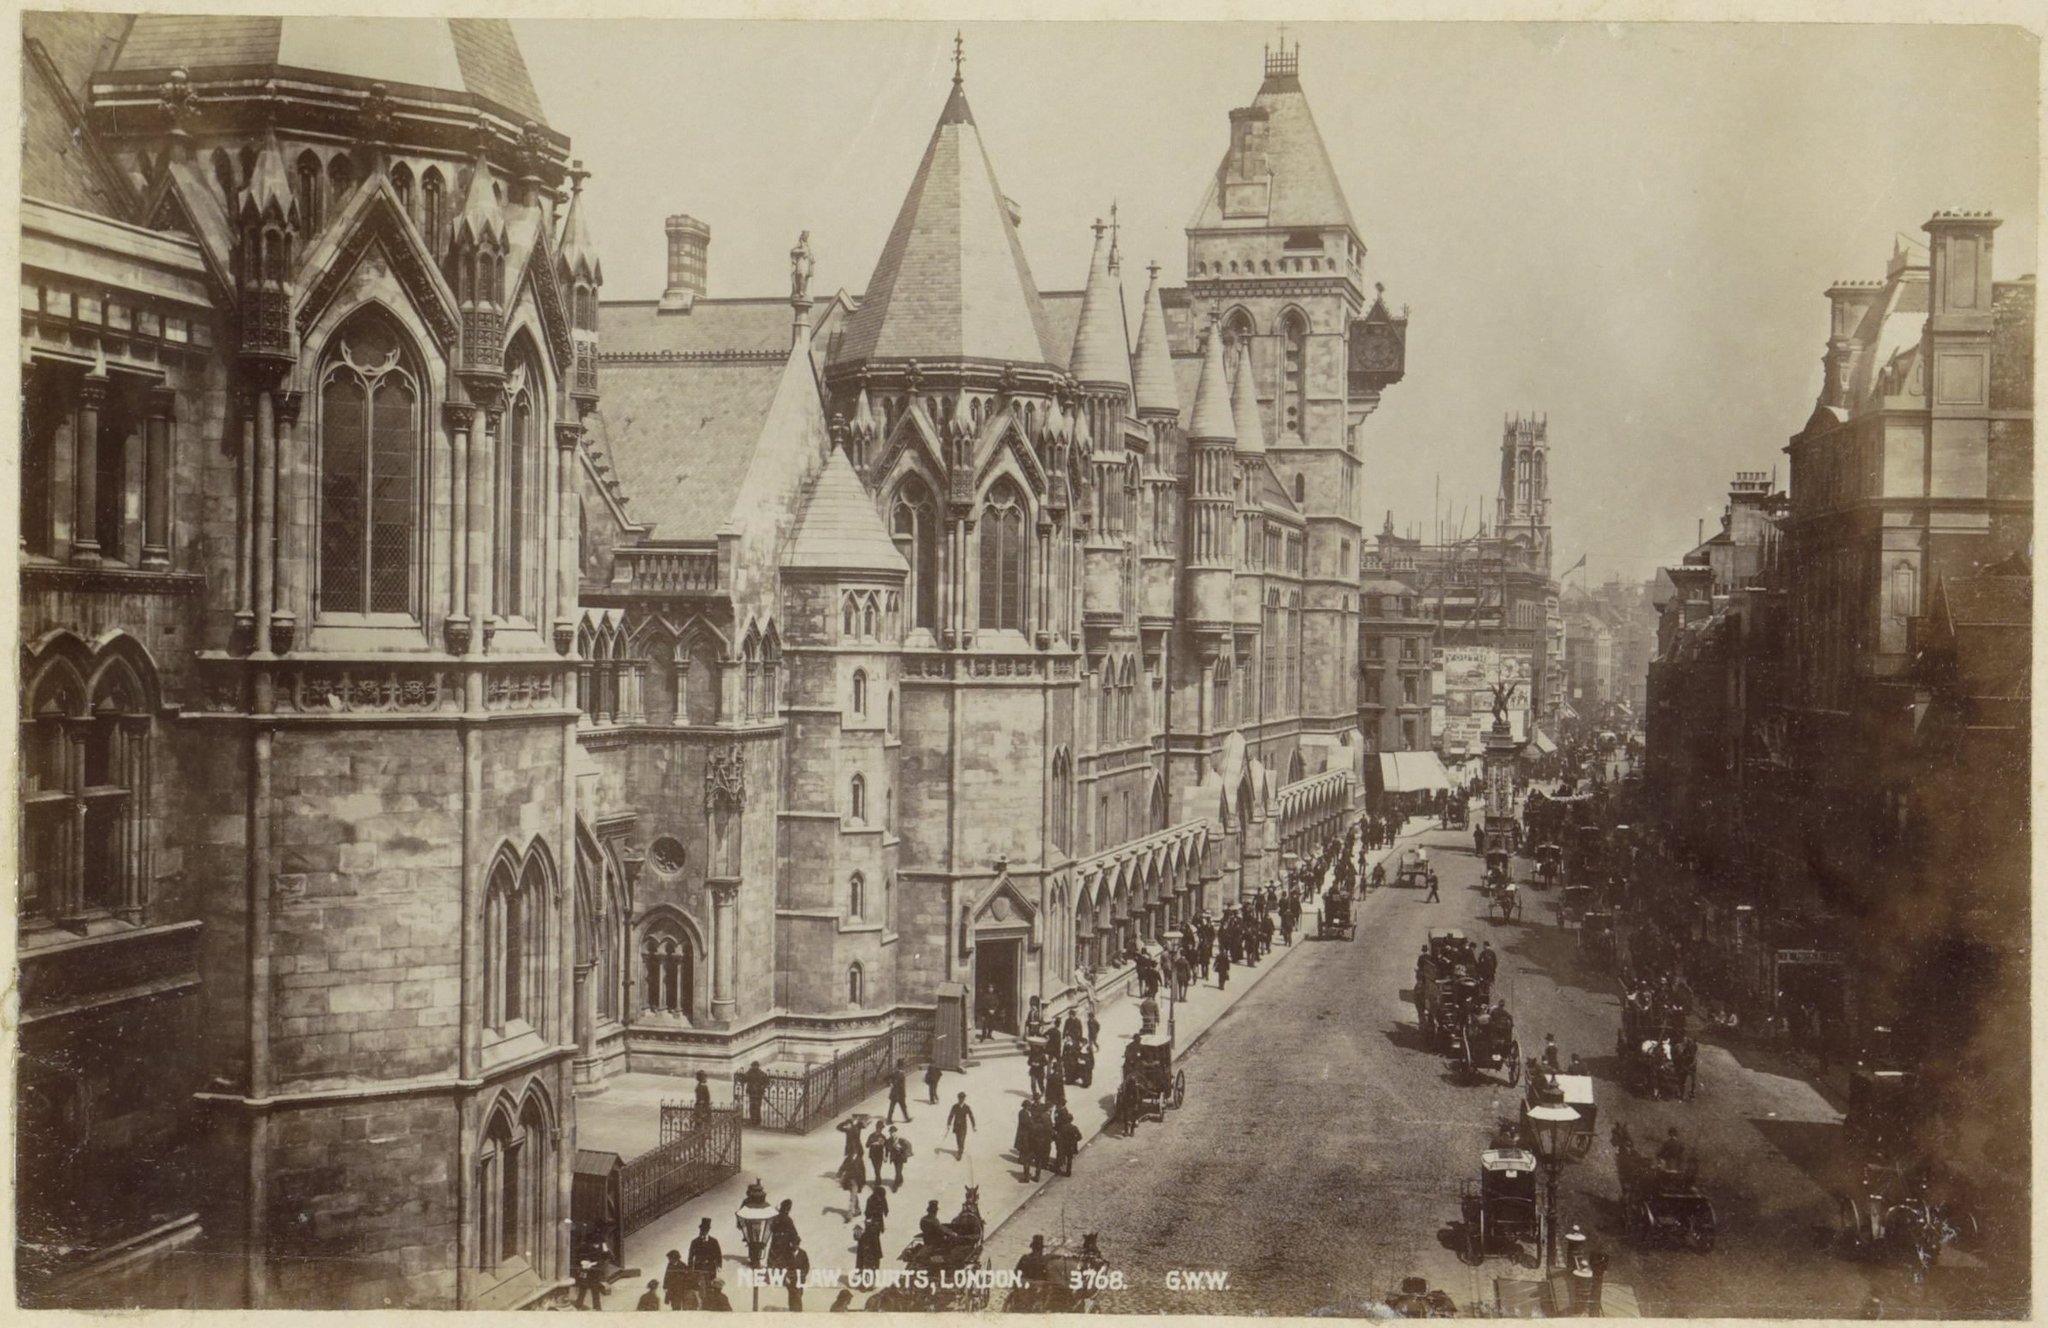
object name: photograph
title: New Law Courts, London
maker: george washington wilson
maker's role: publisher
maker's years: 1823-1893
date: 1870-1890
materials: cardboard, photographic support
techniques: albumen print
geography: london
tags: court building, prospect of city, town panorama, silhouette of city, street (+ city(-scape) with figures, staffage), london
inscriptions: number: ‘3768’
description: Onderdeel van Fotoalbum met bezienswaardigheden in Edinburgh en Londen.